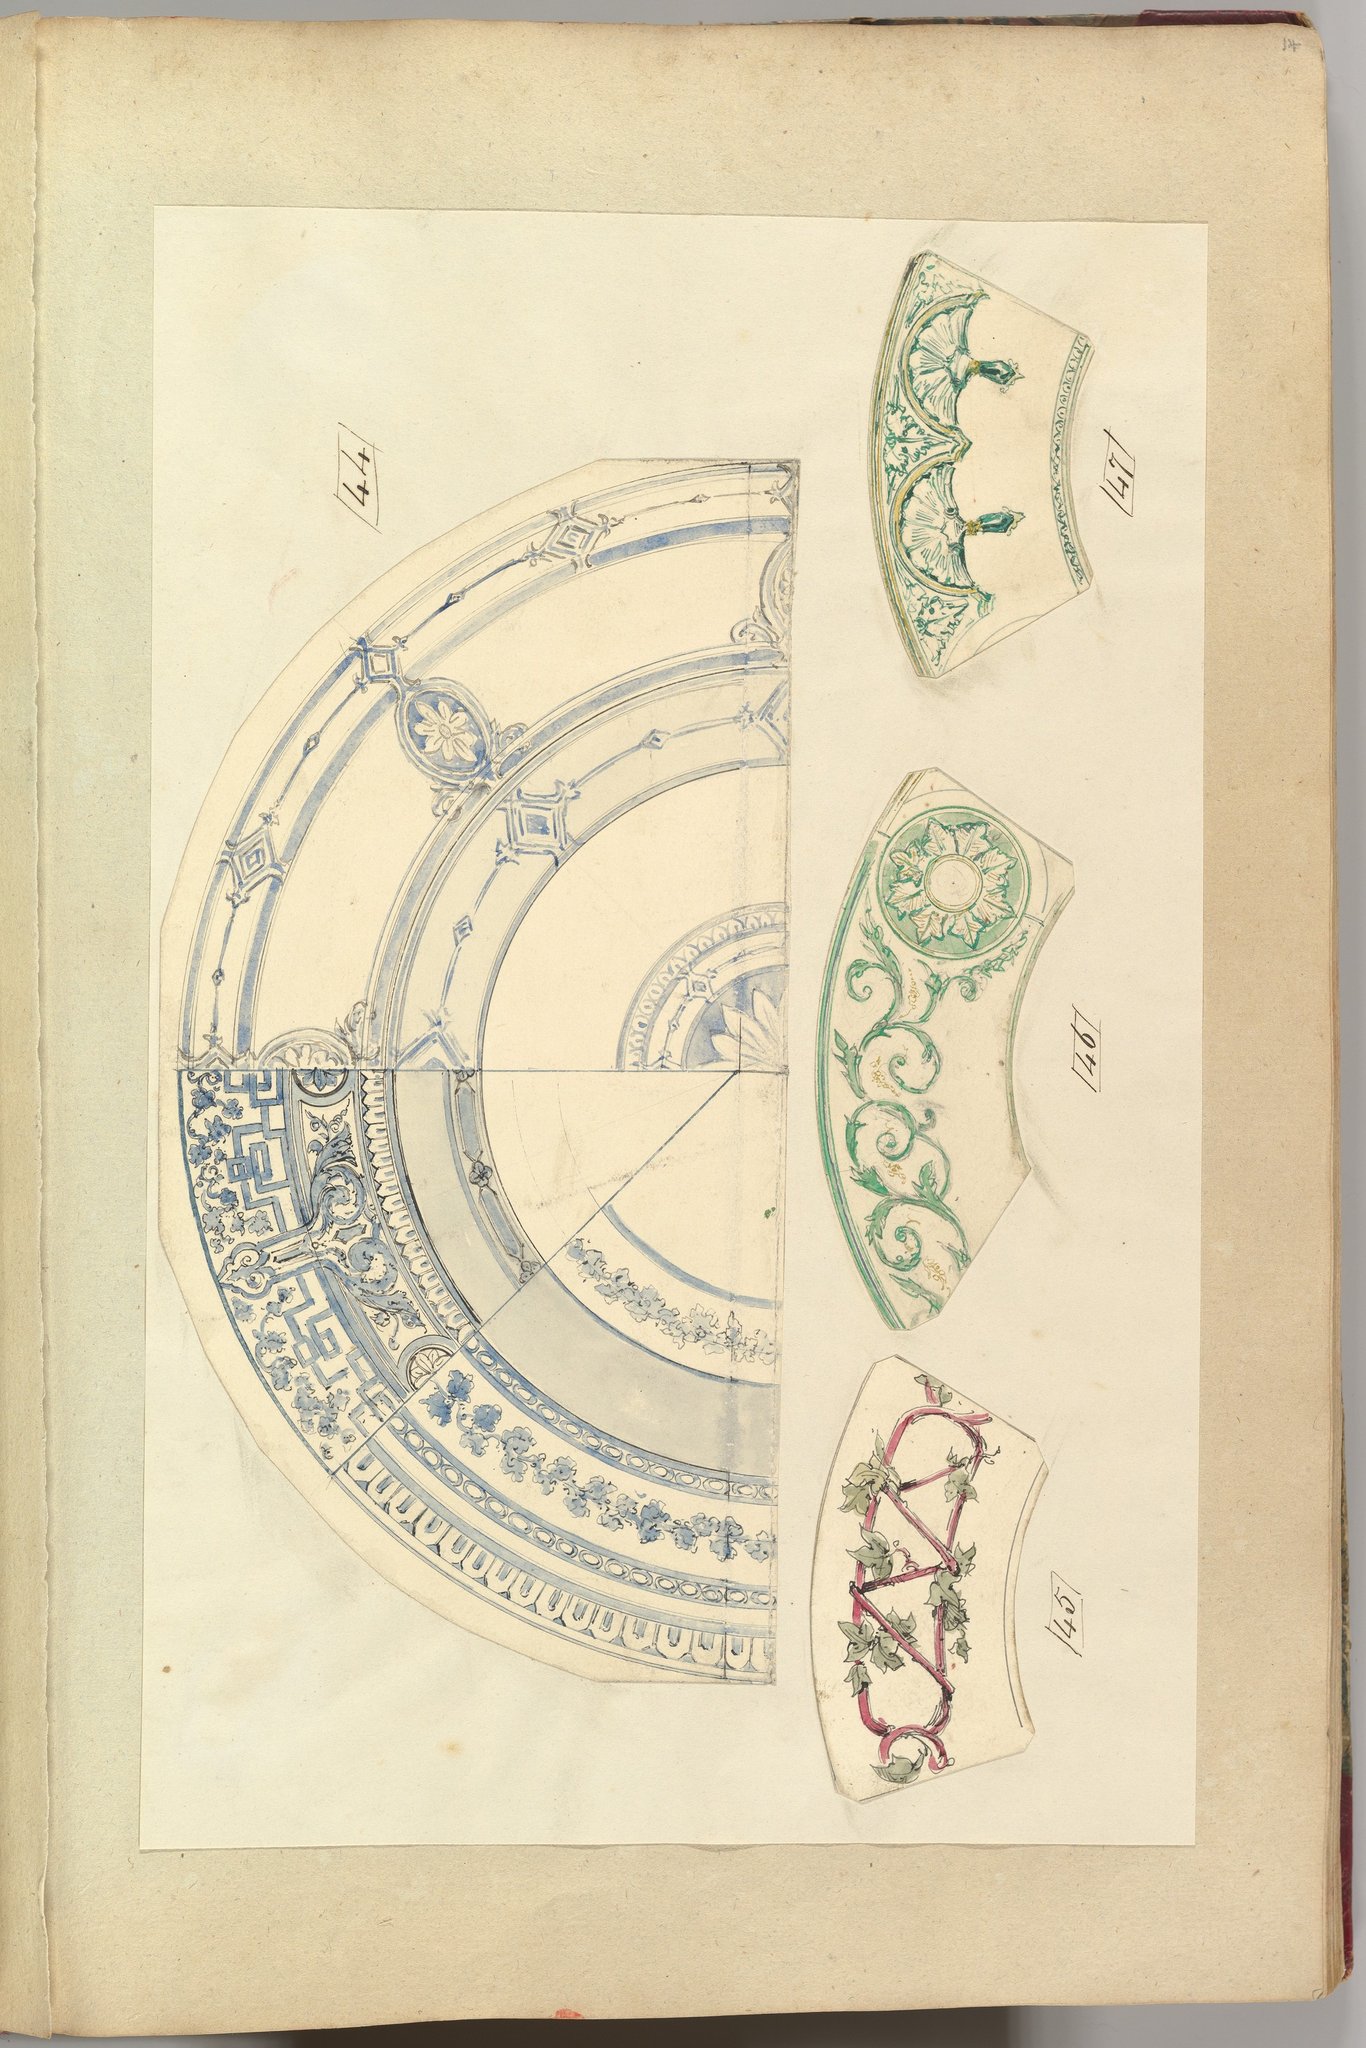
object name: drawing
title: Six Designs for Decorated Plates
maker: alfred henry forrester [alfred crowquill]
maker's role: artist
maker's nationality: british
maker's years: 1804-1872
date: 1845-1855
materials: ink, watercolor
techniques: pen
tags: ornament